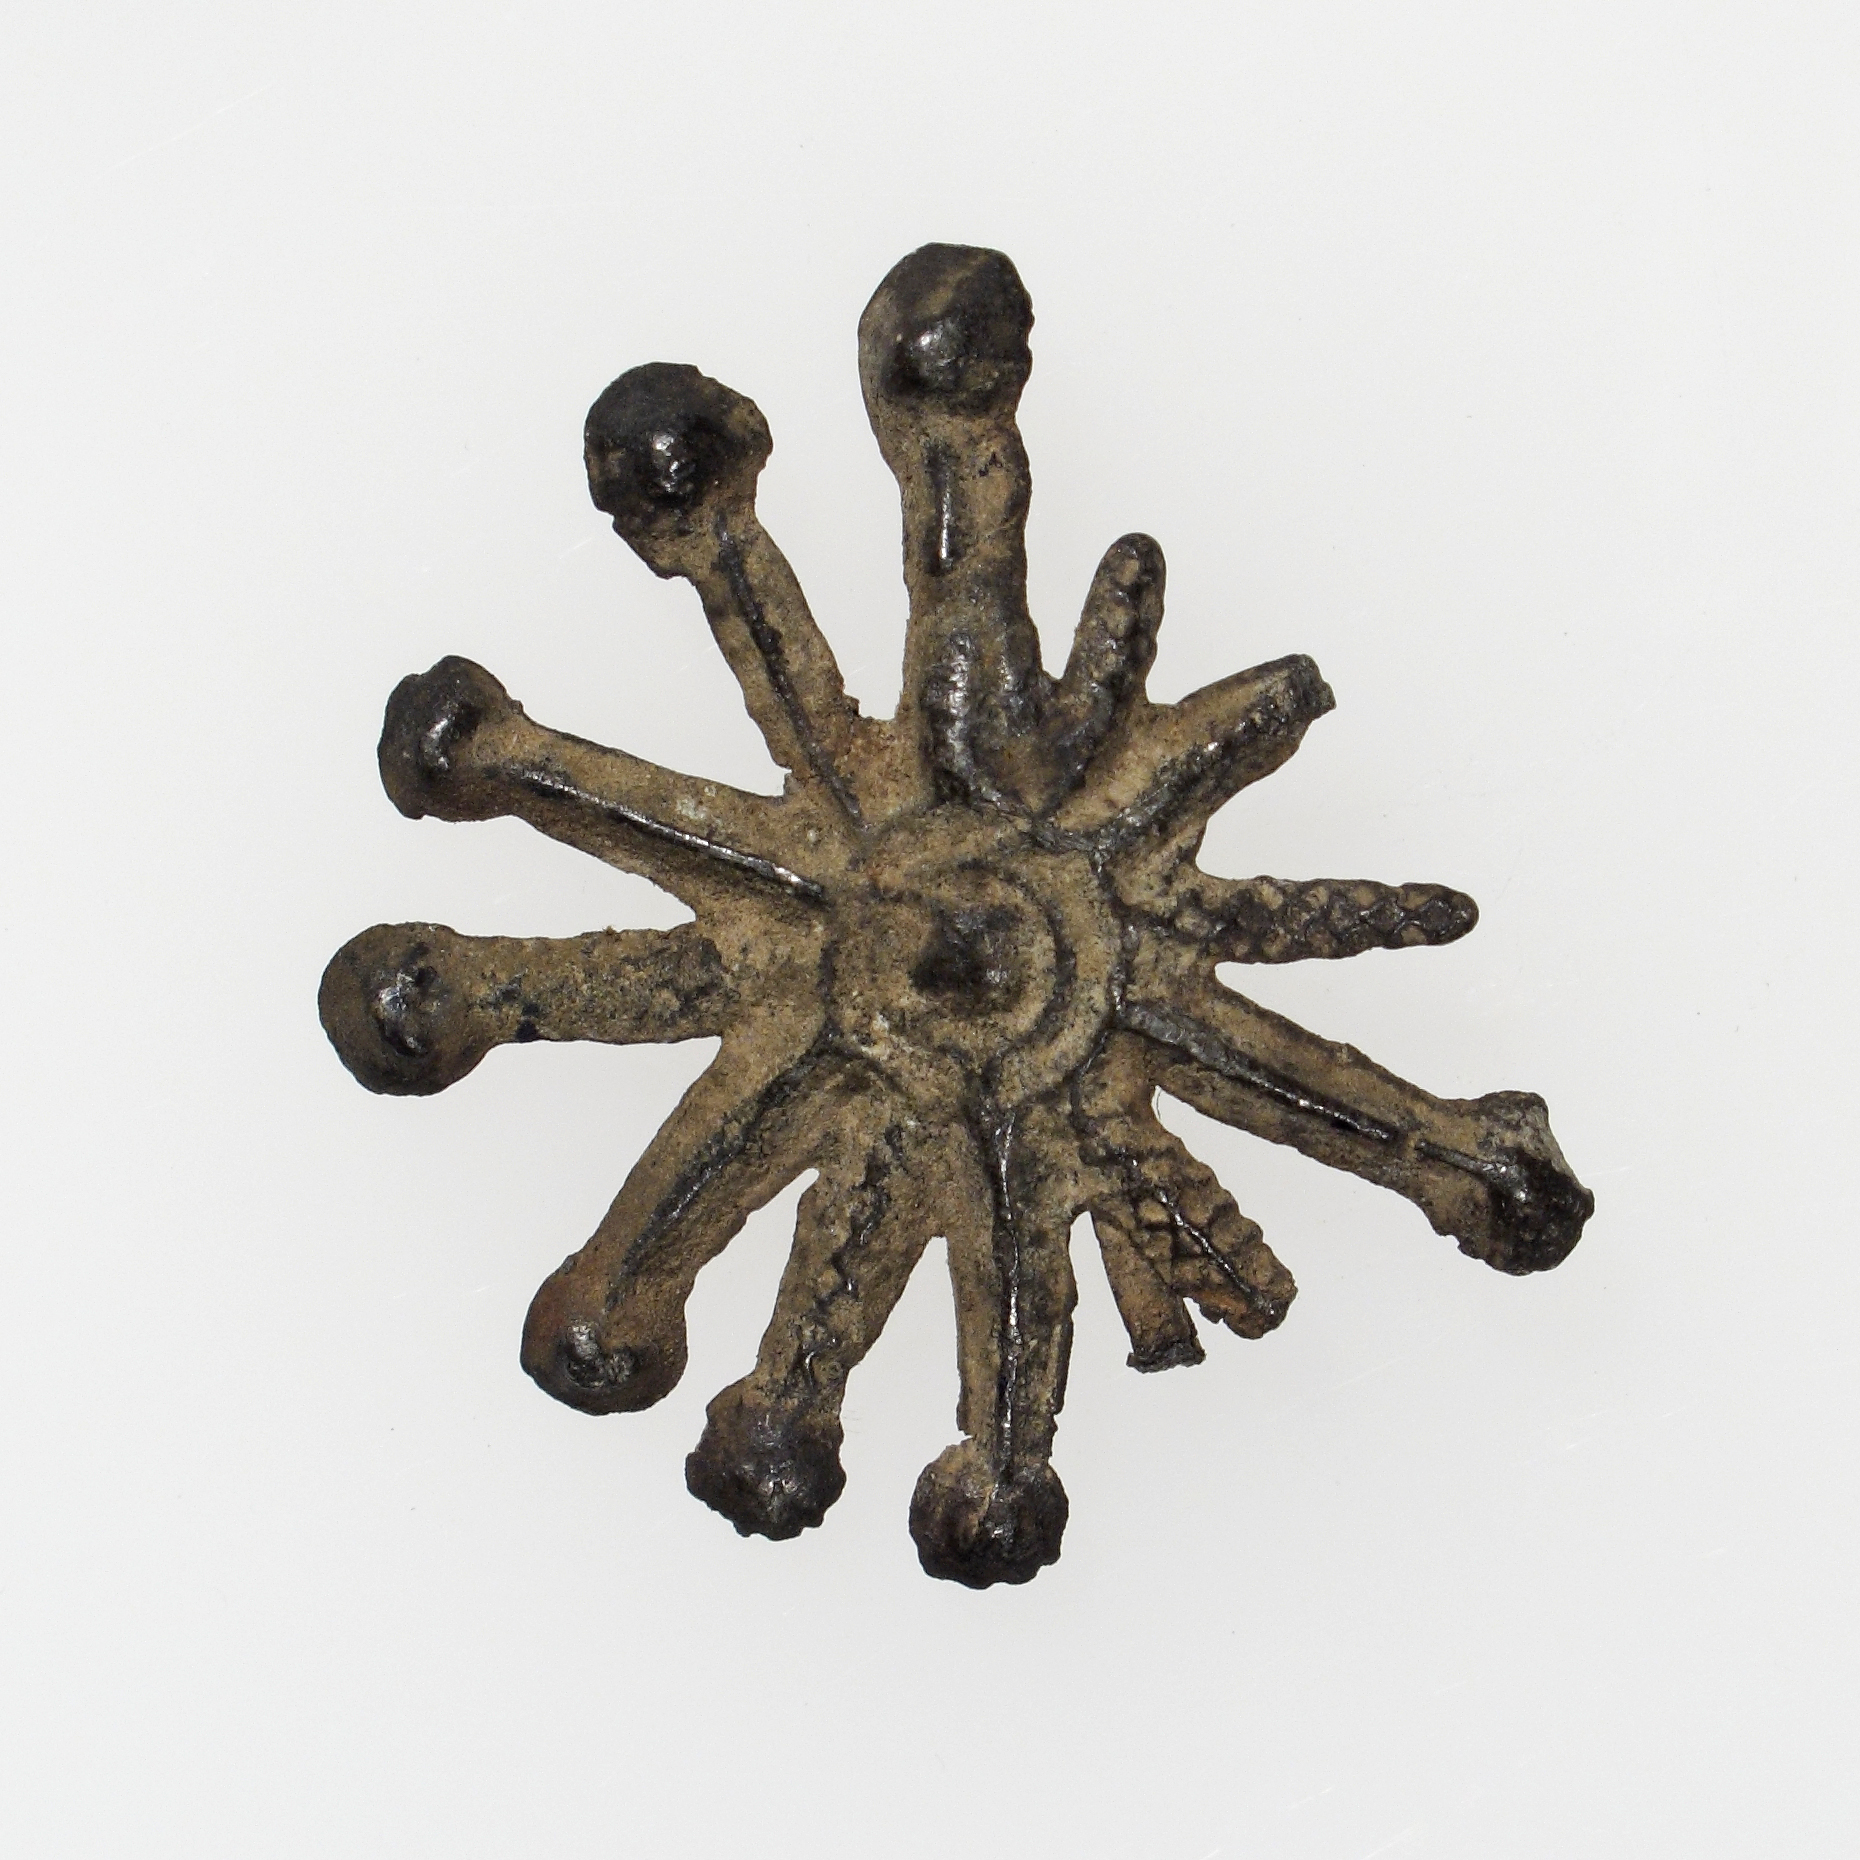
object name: pilgrim's badge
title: Pilgrim's Badge in the form of a solar disk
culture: french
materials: lead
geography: france